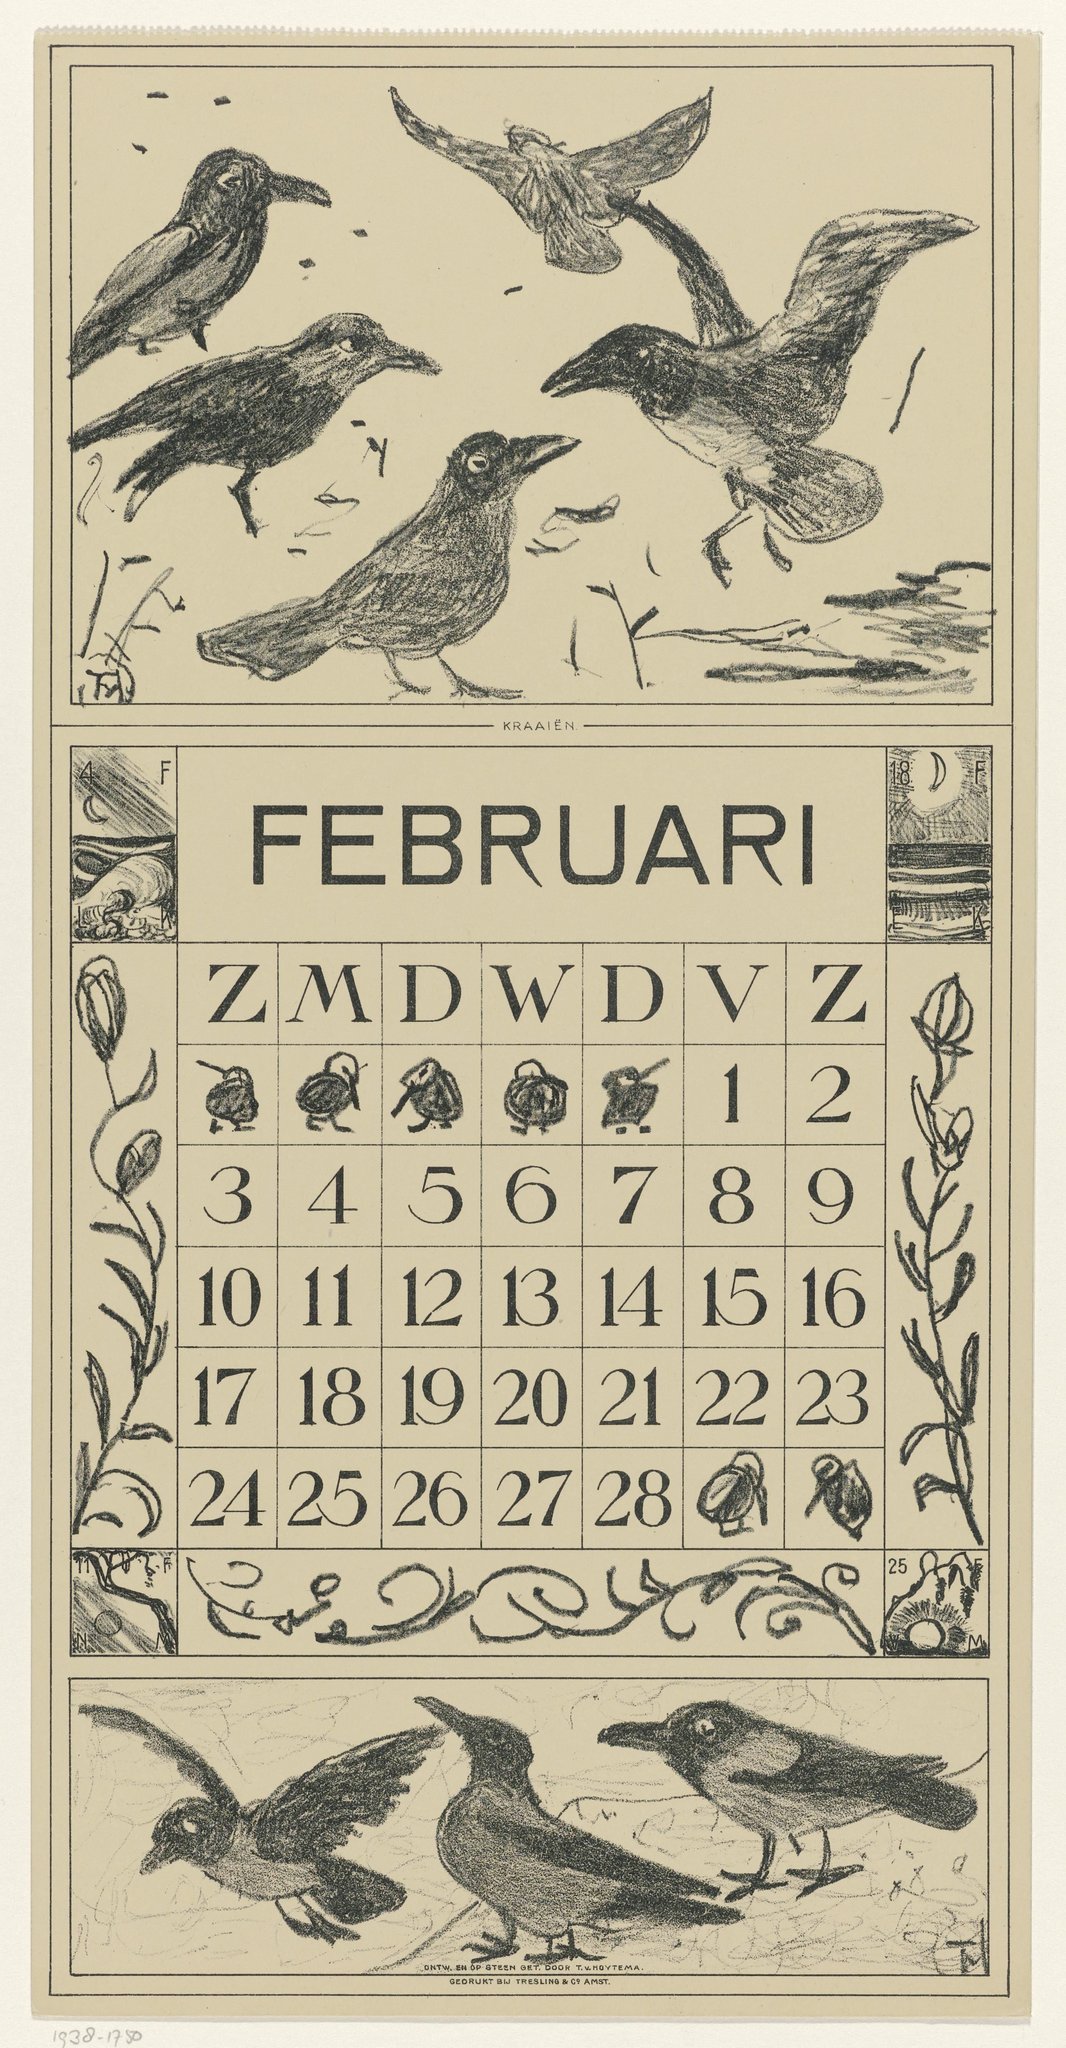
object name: print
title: Kalender 1918 12 lithografien door Th. v. Hoytema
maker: theo van hoytema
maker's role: draughtsman, painter, print maker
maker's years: 1863-1917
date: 1917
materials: paper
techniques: lithograph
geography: amsterdam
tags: song-birds: crow, lunar year, february ~ other concepts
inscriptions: collector's mark: Lugt 2228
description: In de hoeken de standen van de maan op vier dagen. Bovenaan het blad een scheurlijn.